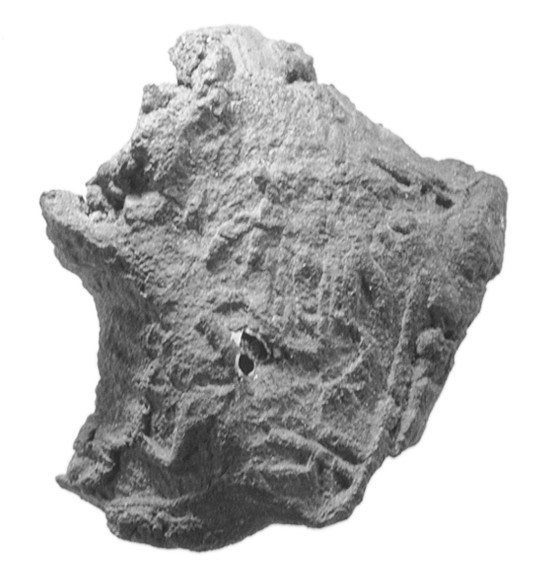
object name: sealing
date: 2030-1640 BCE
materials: clay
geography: egypt